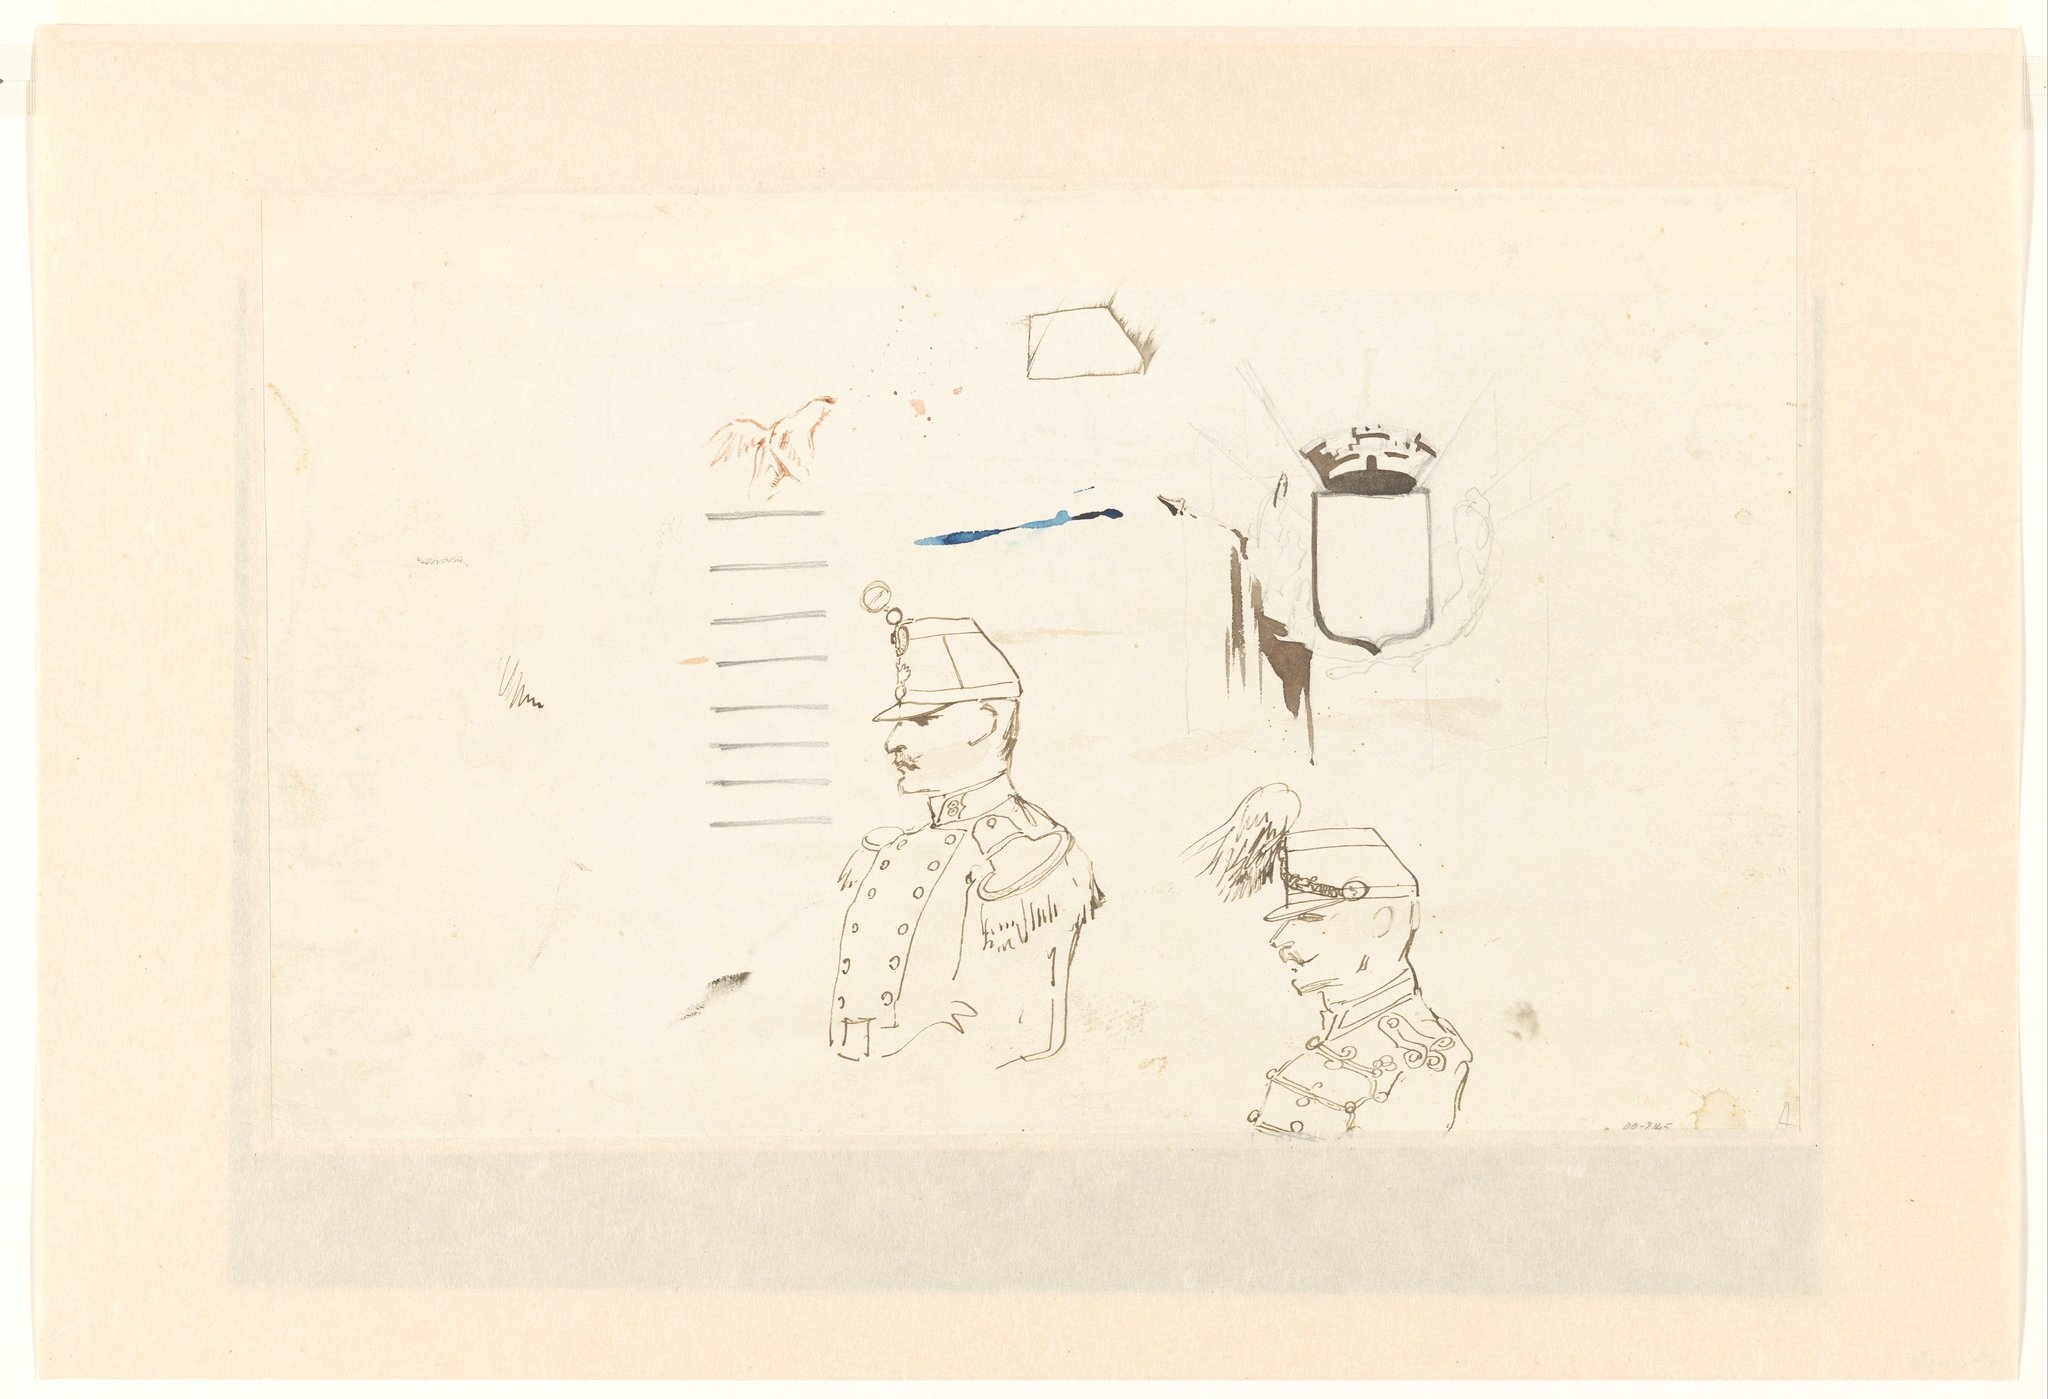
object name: drawing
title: Schetsblad met twee studies van een militair en een schets van een wapen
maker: louis charles bombled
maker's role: draughtsman, print maker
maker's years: 1862-1927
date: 1872-1927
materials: ink, paper, pencil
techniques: pen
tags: officer